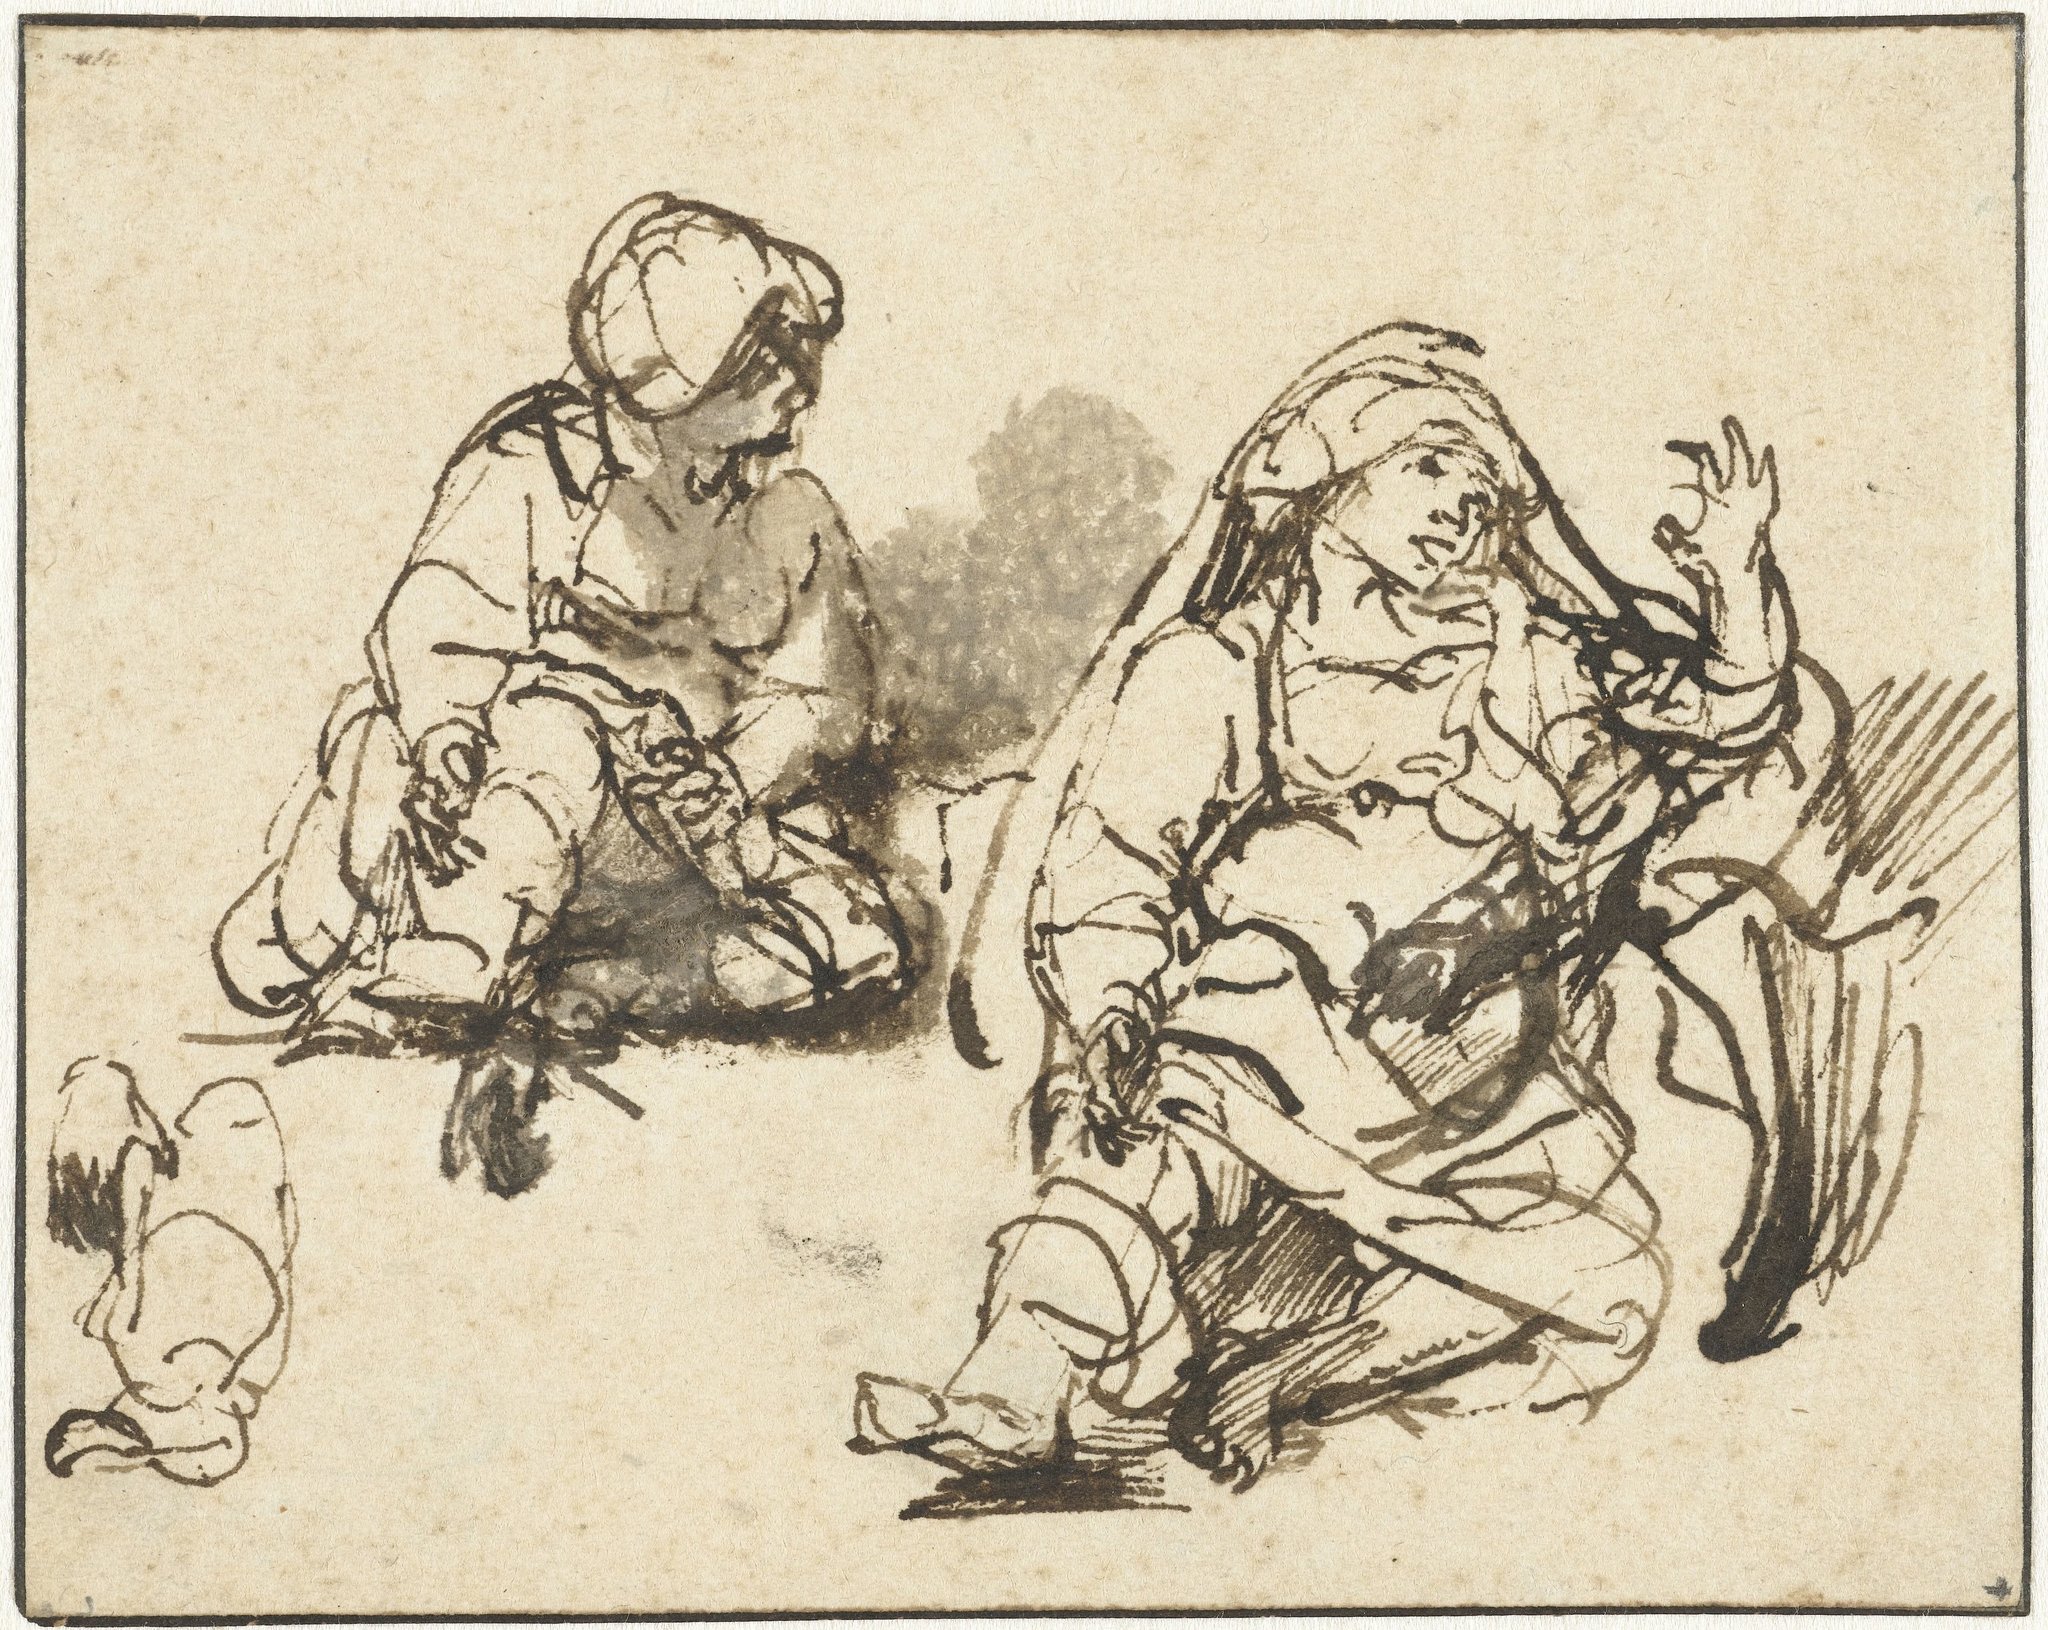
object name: drawing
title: Studies for the Sick Woman in the ‘Hundred Guilder Print’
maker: rembrandt van rijn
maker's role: draughtsman, painter, print maker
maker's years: 1606-1669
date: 1648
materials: paint, ink, paper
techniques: brush, pen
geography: amsterdam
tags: adult woman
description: While Rembrandt seldom made specific preparatory designs for his etchings, he occasionally tried out new motifs in drawings. Here, he explored various poses for the sick woman lying before Jesus in the ‘Hundred Guilder print.’ The seated woman on the left keeps her hands lowered, while the other, semi-reclining woman raises one hand to attract Jesus’ attention. In the print, Rembrandt went for a greater dramatic effect, portraying her with barely enough strength to lift her arm.